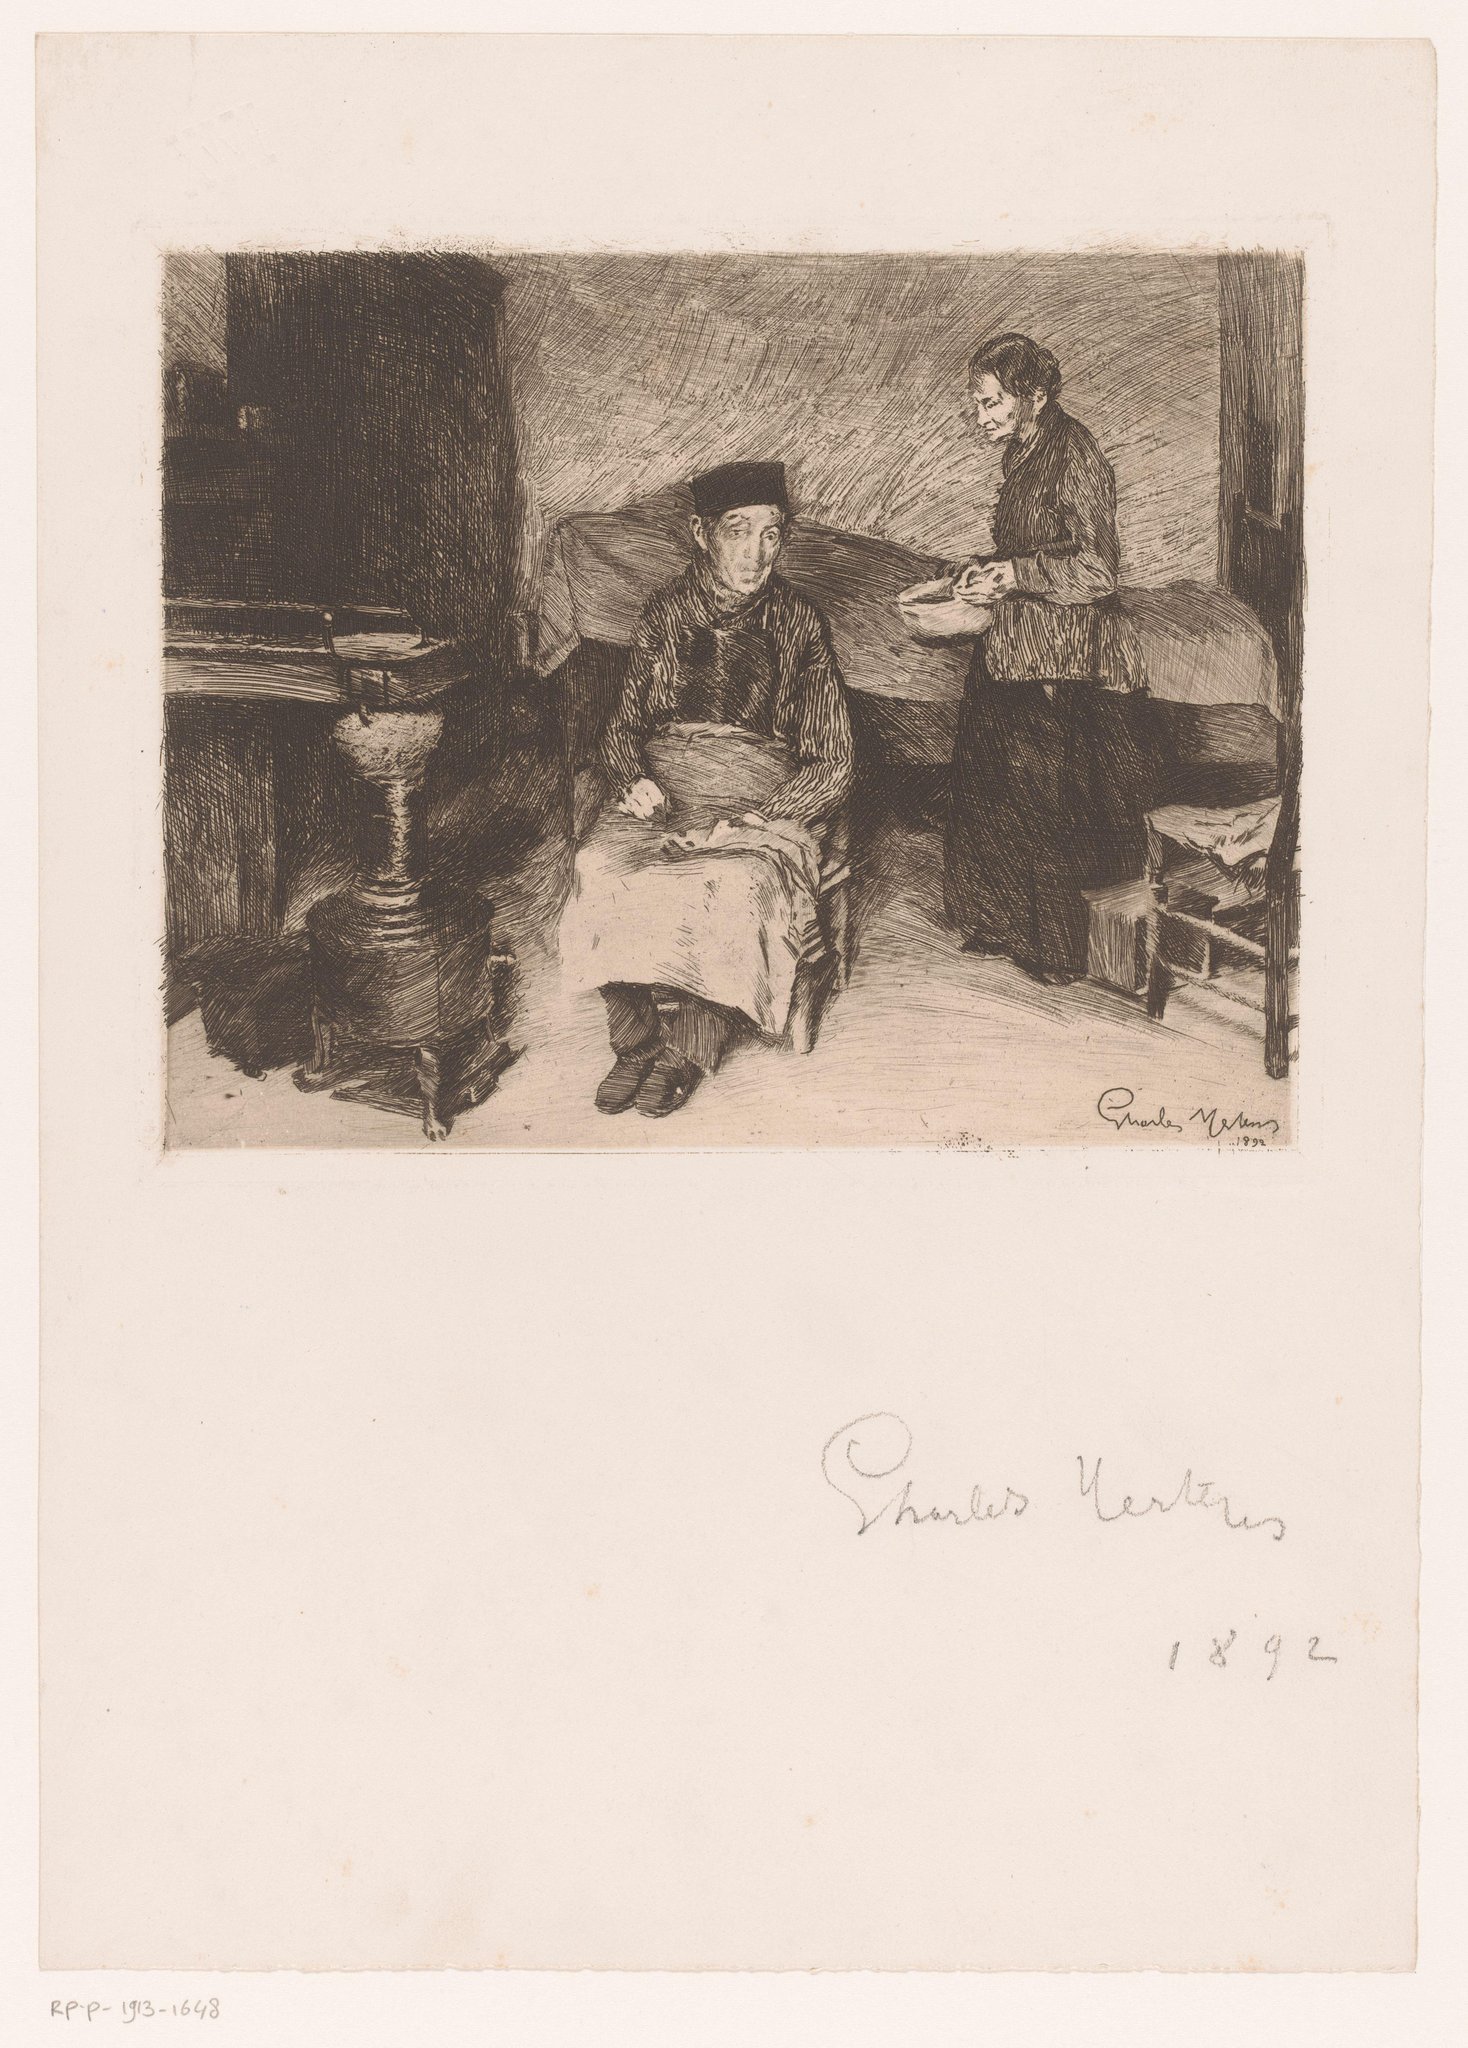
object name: print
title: Interieur met een man gezeten op een stoel en een vrouw met een kamerpot in haar handen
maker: charles mertens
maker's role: print maker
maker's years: 1865-1919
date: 1892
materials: paper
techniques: etching, intaglio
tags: old man, old woman, bed, chamber-pot, interior ~ representation of a building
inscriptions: collector's mark: Lugt 2228